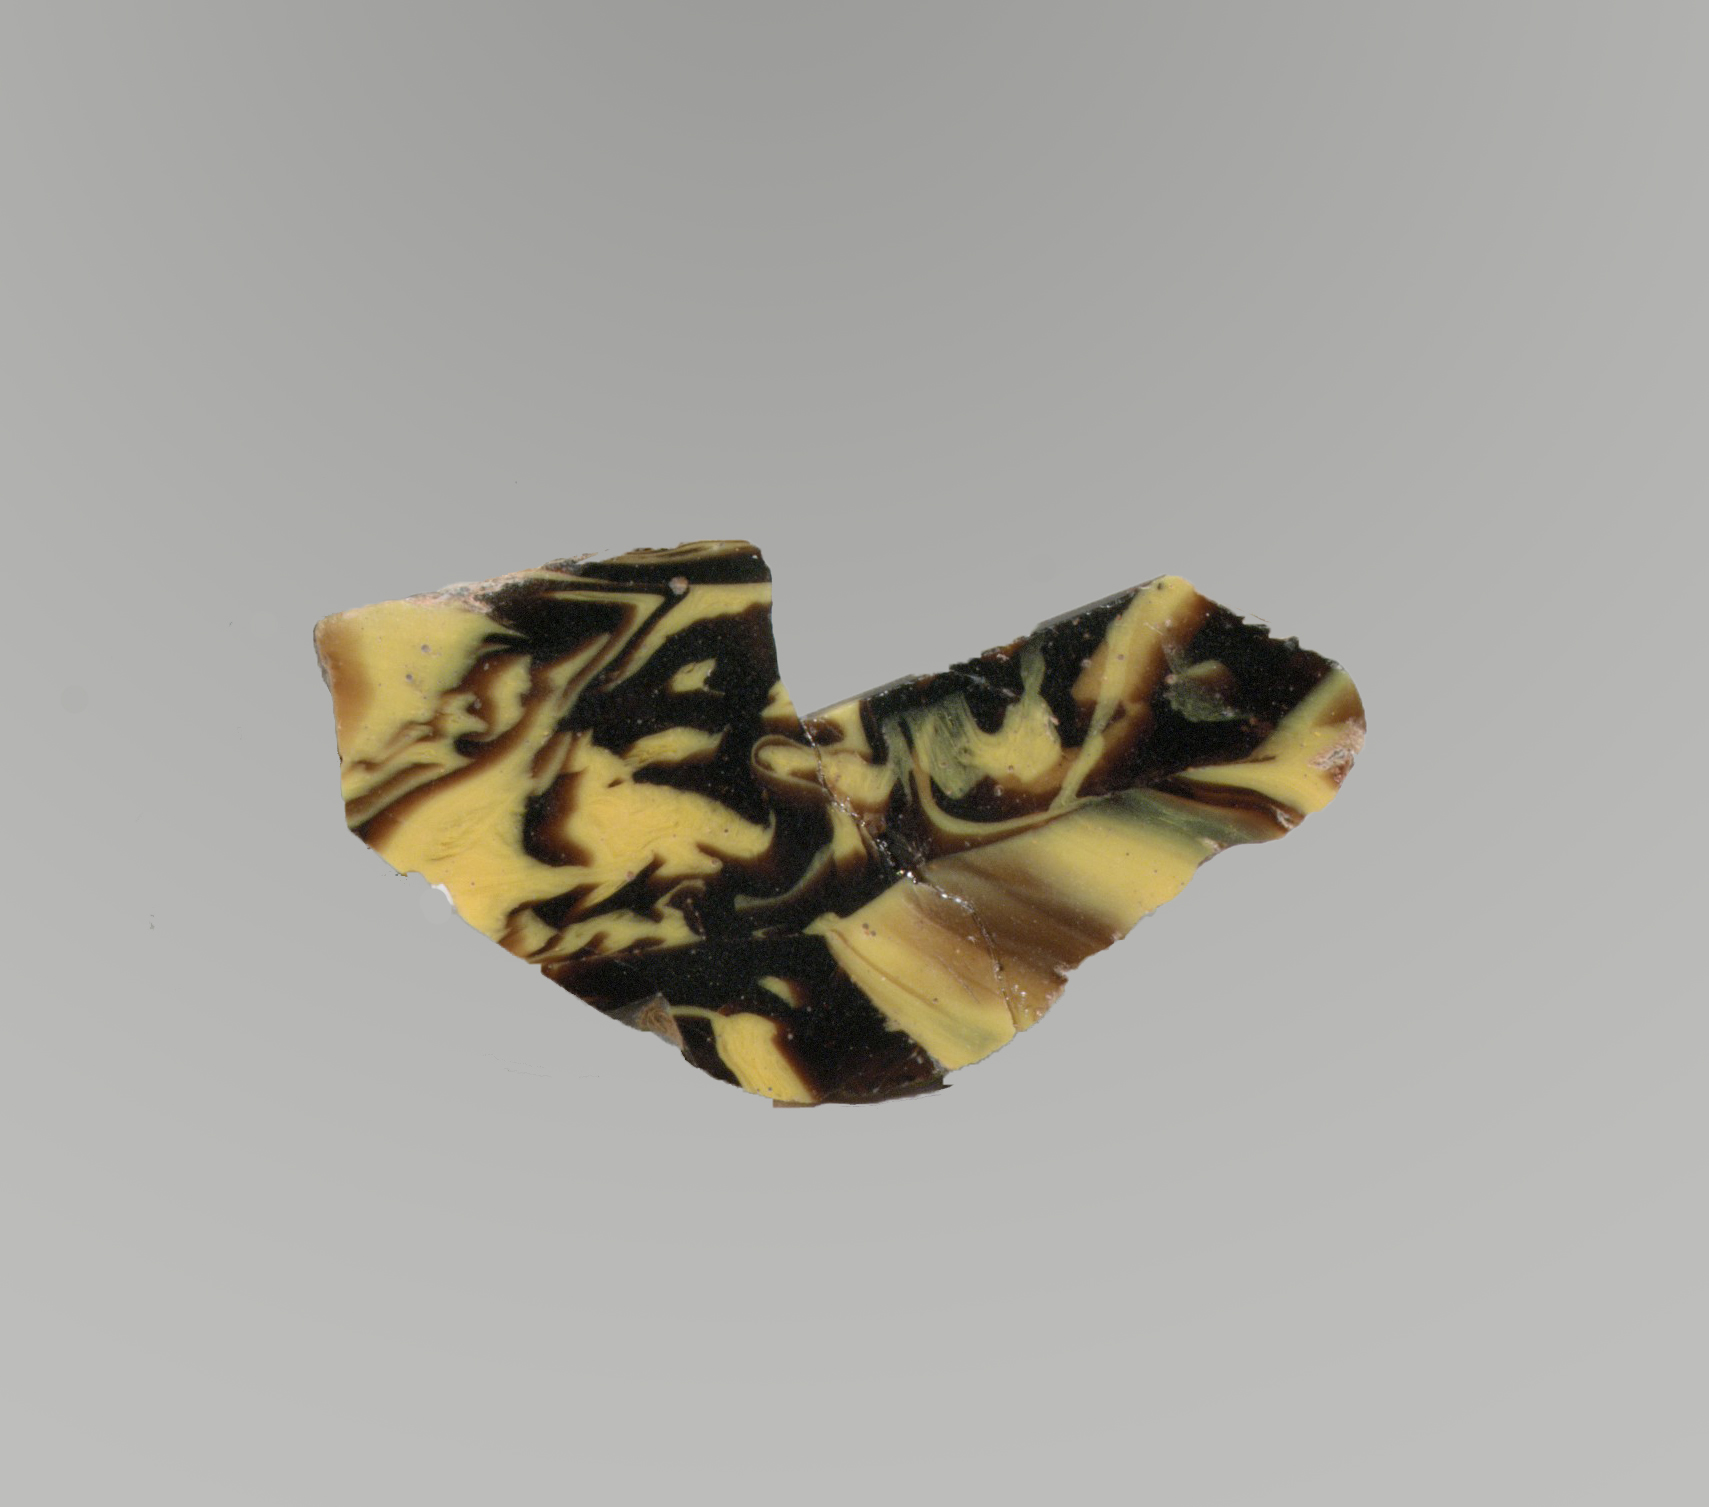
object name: fragment, mosaic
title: Glass mosaic inlay fragment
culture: roman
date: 34 BCE-33 CE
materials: glass